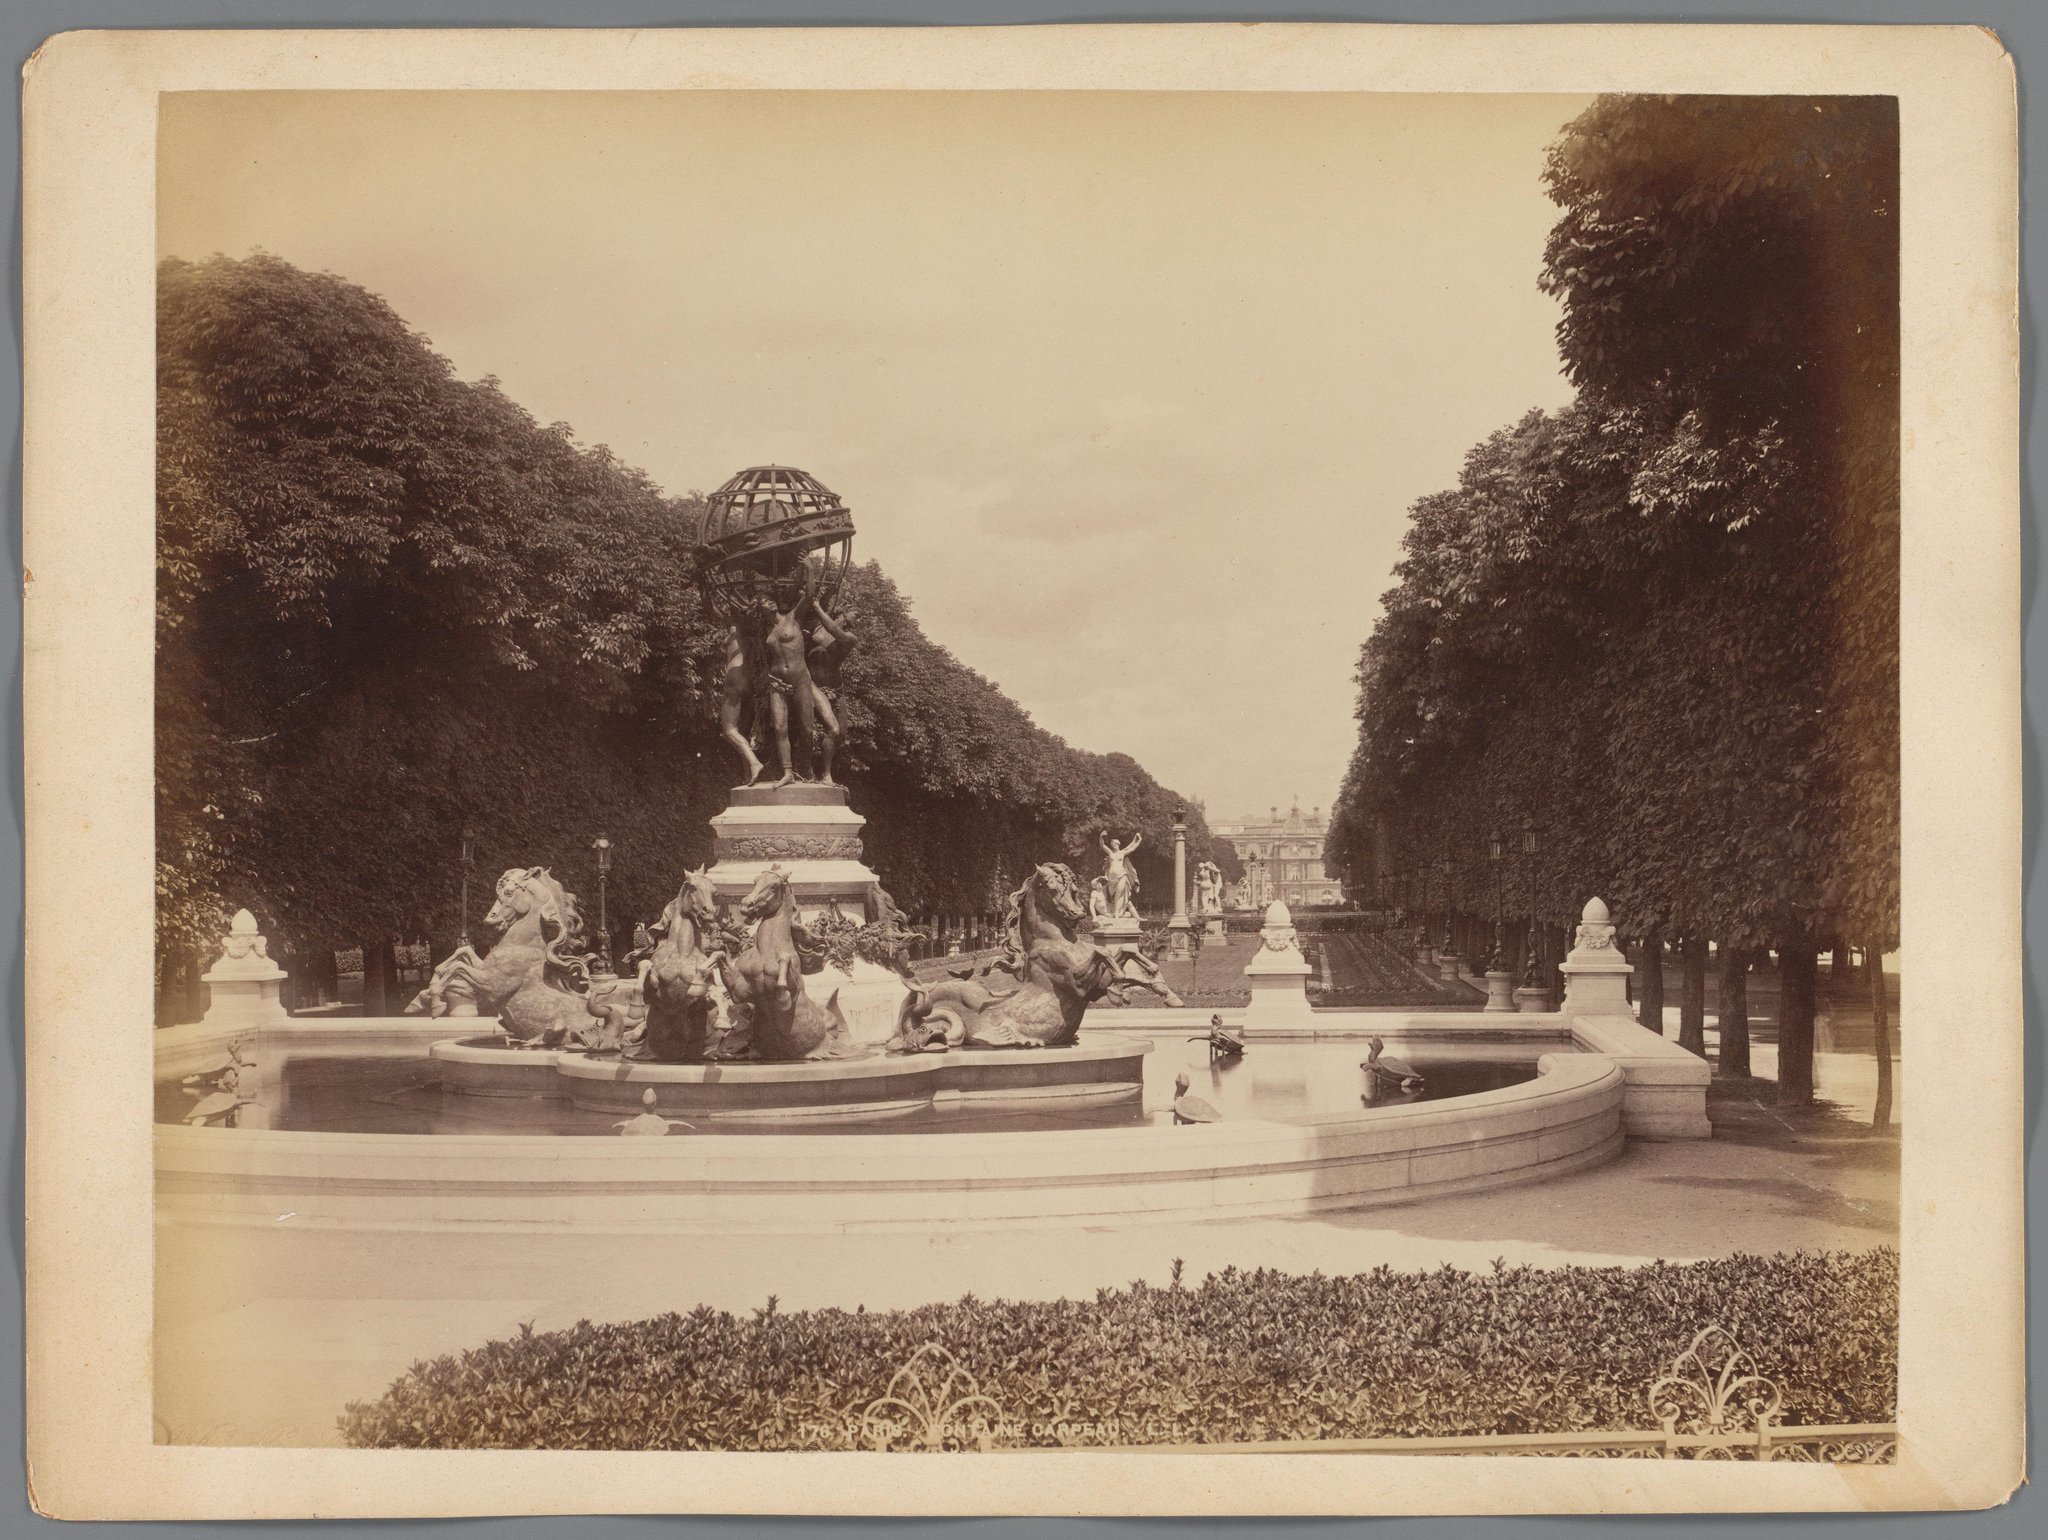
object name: photograph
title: Fontaine Carpeau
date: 1864-1895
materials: cardboard, paper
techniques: albumen print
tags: ornamental fountain, public gardens, park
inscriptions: number: ‘176.’